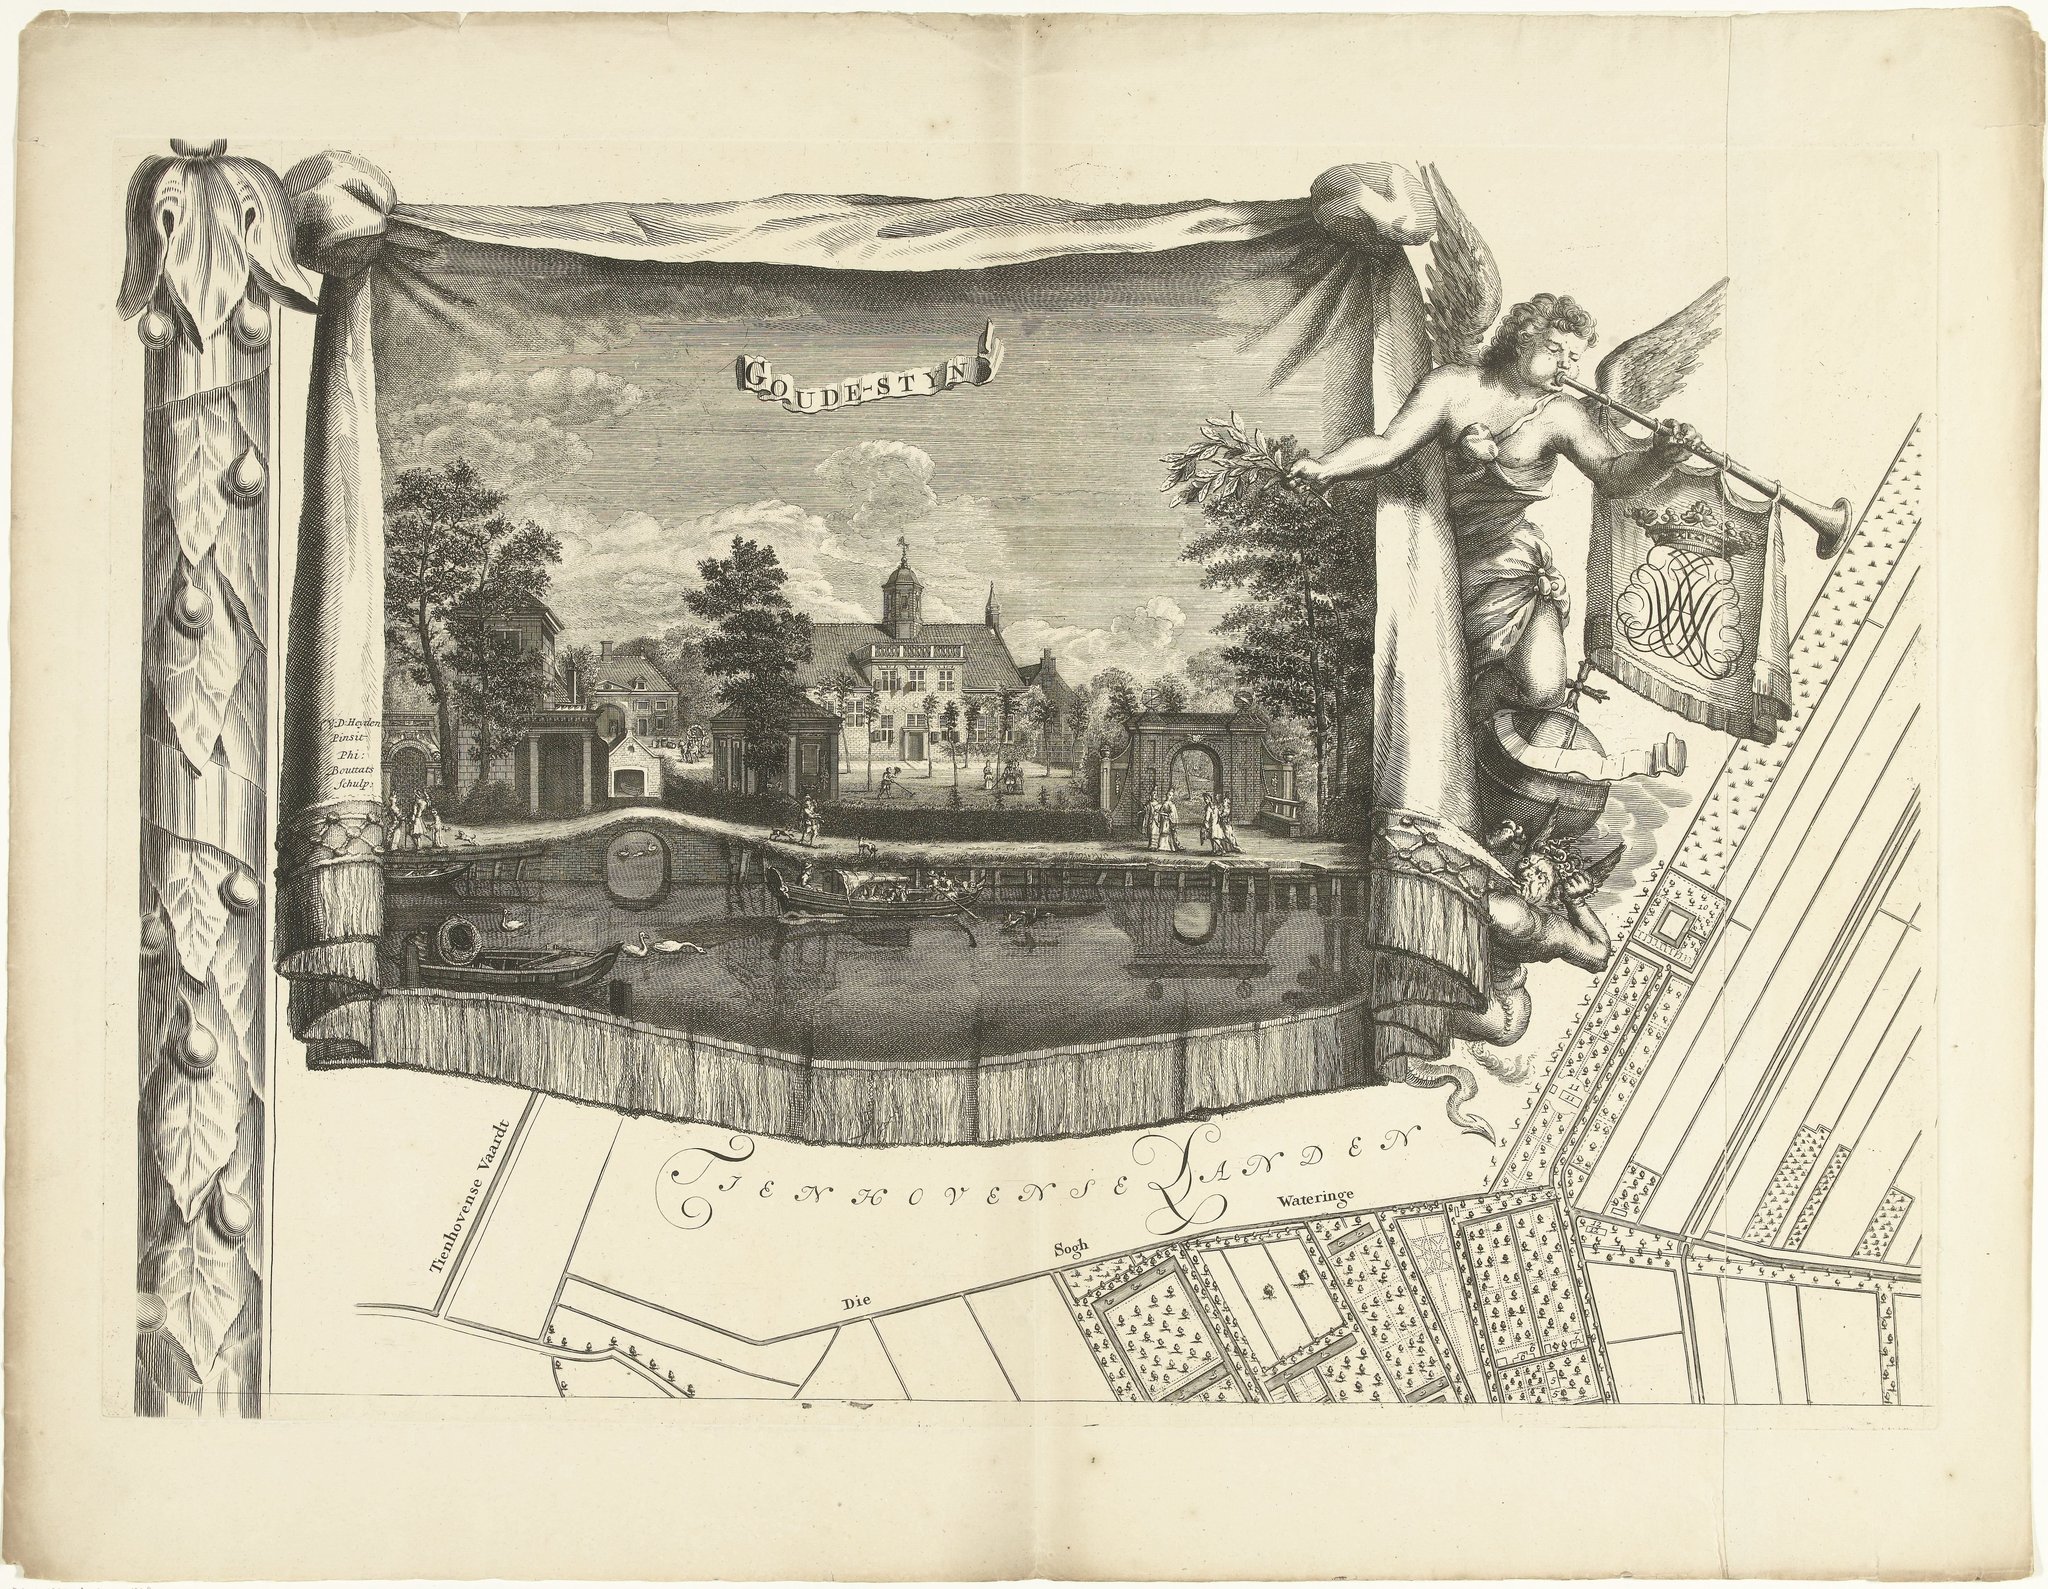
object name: area plan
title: Plattegrond van de heerlijkheid Maarsseveen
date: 1690-1691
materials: paper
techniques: engraving, etching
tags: christian religion (+ devil(s)), fame; 'fama', 'fama buona', 'fama chiara' (ripa), maps of cities, farm or solitary house in landscape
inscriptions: collector's mark: Lugt 2228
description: Linkerbovenplaat. De plattegrond van een gedeelte van de heerlijkheid Maarsseveen. Een grote banderol met gezicht op Goudestein, een buitenplaats in de heerlijkheid Maarsseveen. Langs de rivier de Vecht wandelen verschillende paartjes en een herder. Op de rivier varen enkele bootjes en zwemmen zwanen. Op de achtergrond het buitenverblijf Goudenstein. Vanachter de banderol komt de allegorische figuur van Roem. Zij blaast op een trompet met een vaandel en verjaagt een duivel.